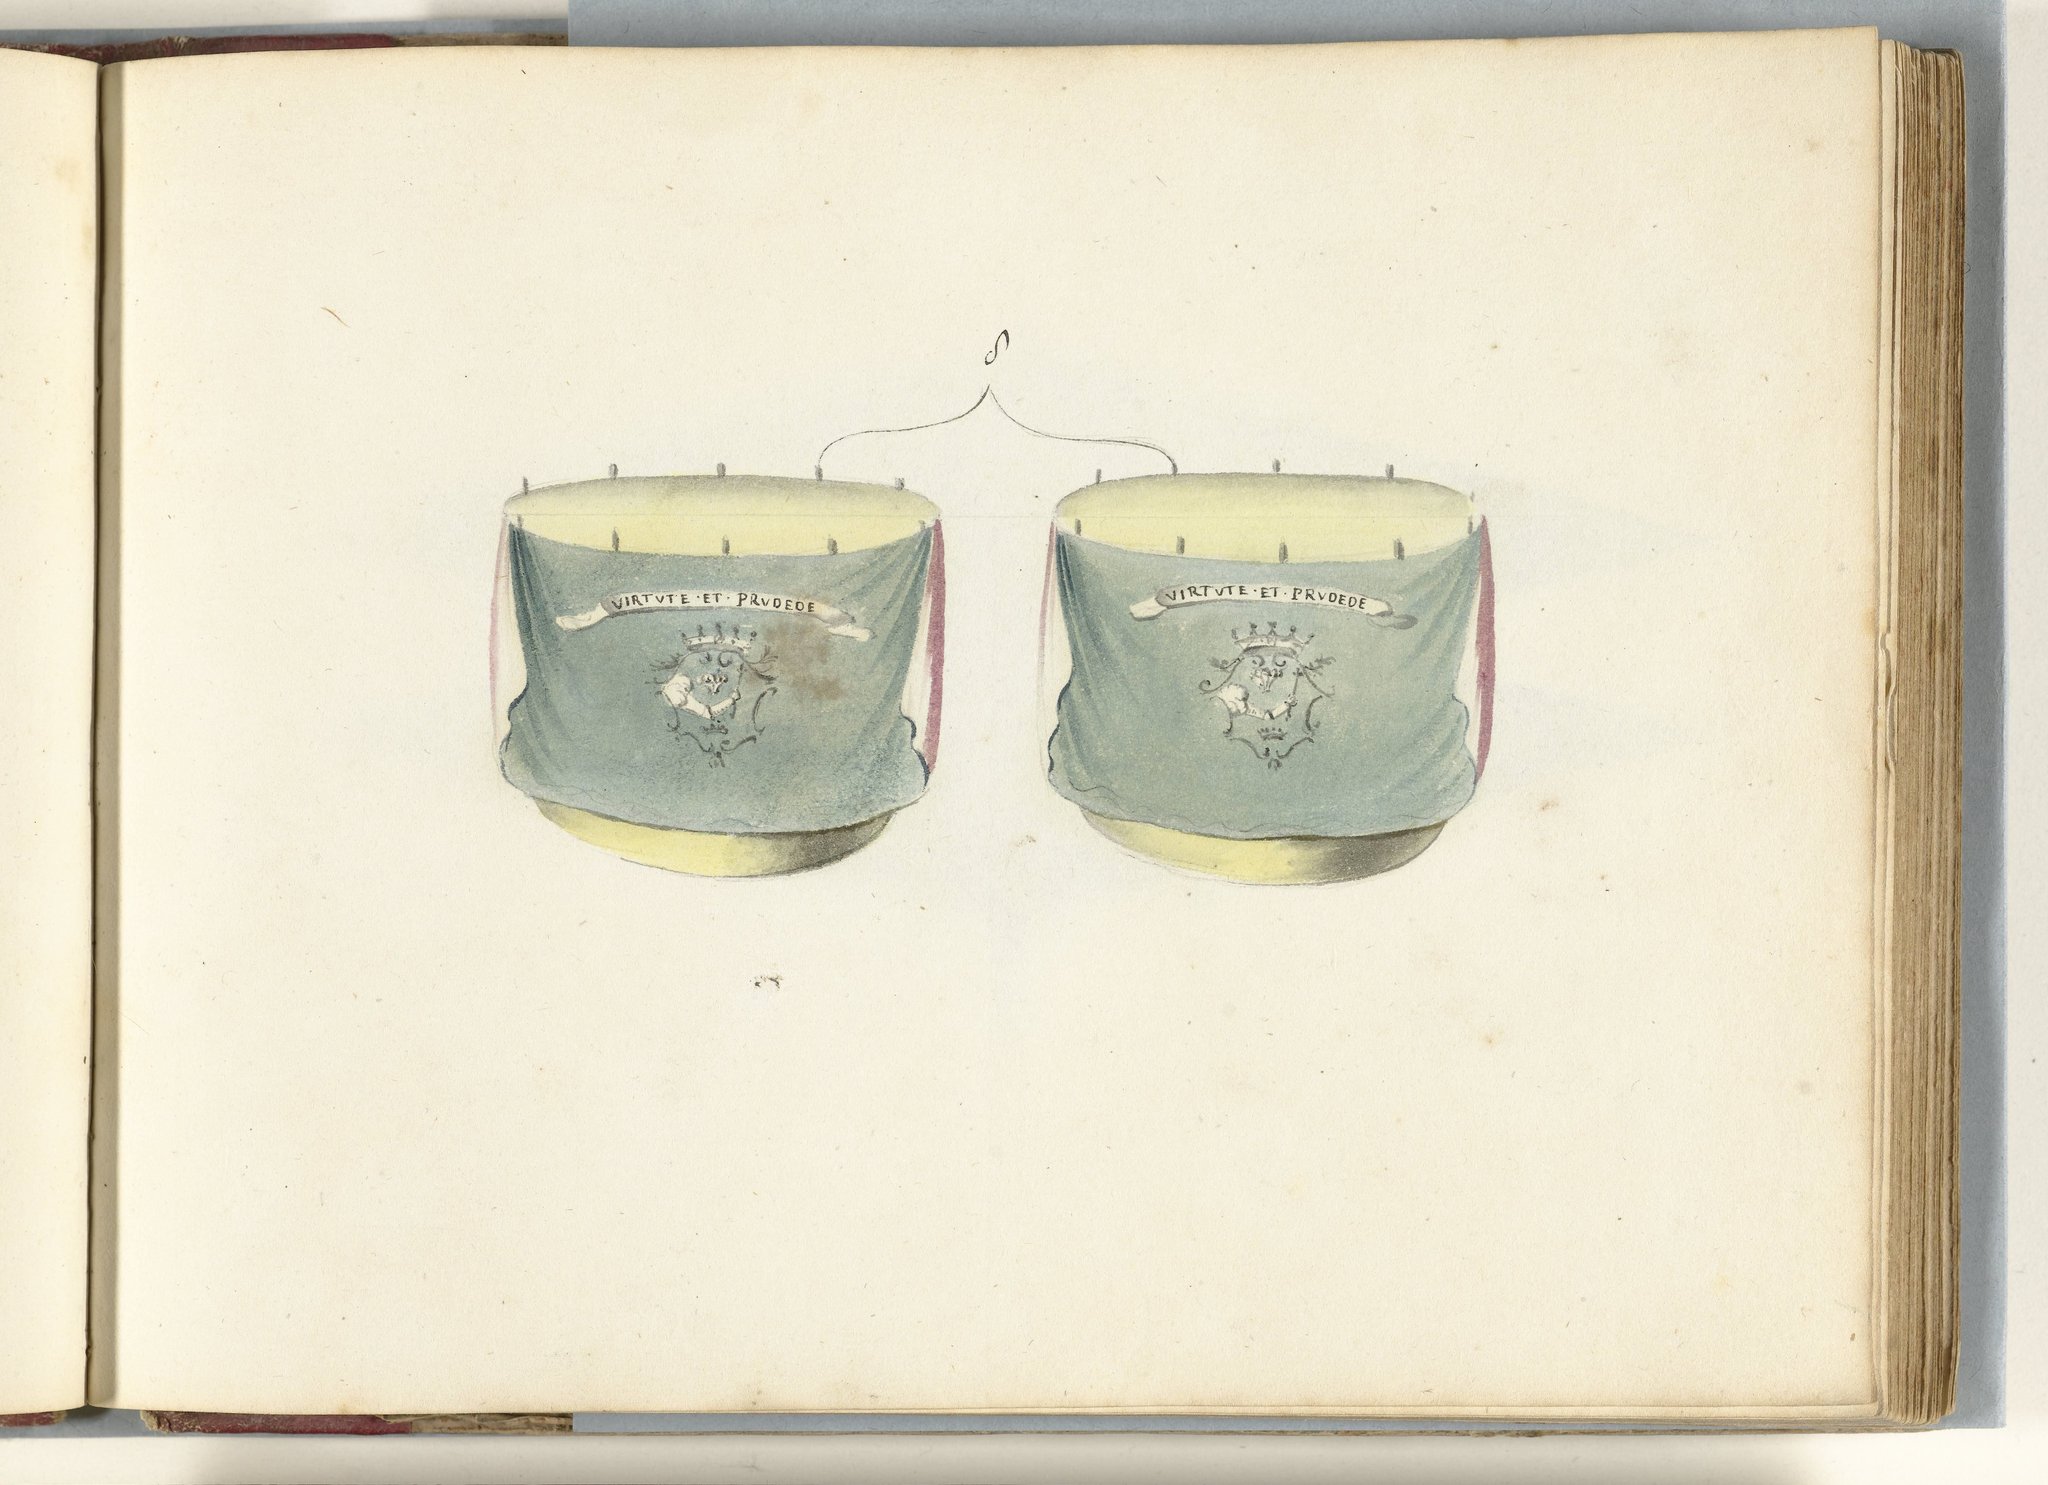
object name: drawing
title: Twee Franse pauken, veroverd in de slag bij Oudenaarde, 1708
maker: Anonymous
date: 1713-1720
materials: paper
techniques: drawing, writing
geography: northern netherlands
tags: military music, drum (musical instrument)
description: Twee Franse pauken, veroverd bij de slag bij Oudenaarde in 1708. In het boek met tekeningen van Franse vaandels, standaarden en pauken, veroverd tijdens de Spaanse Successieoorlog (1701-1713).